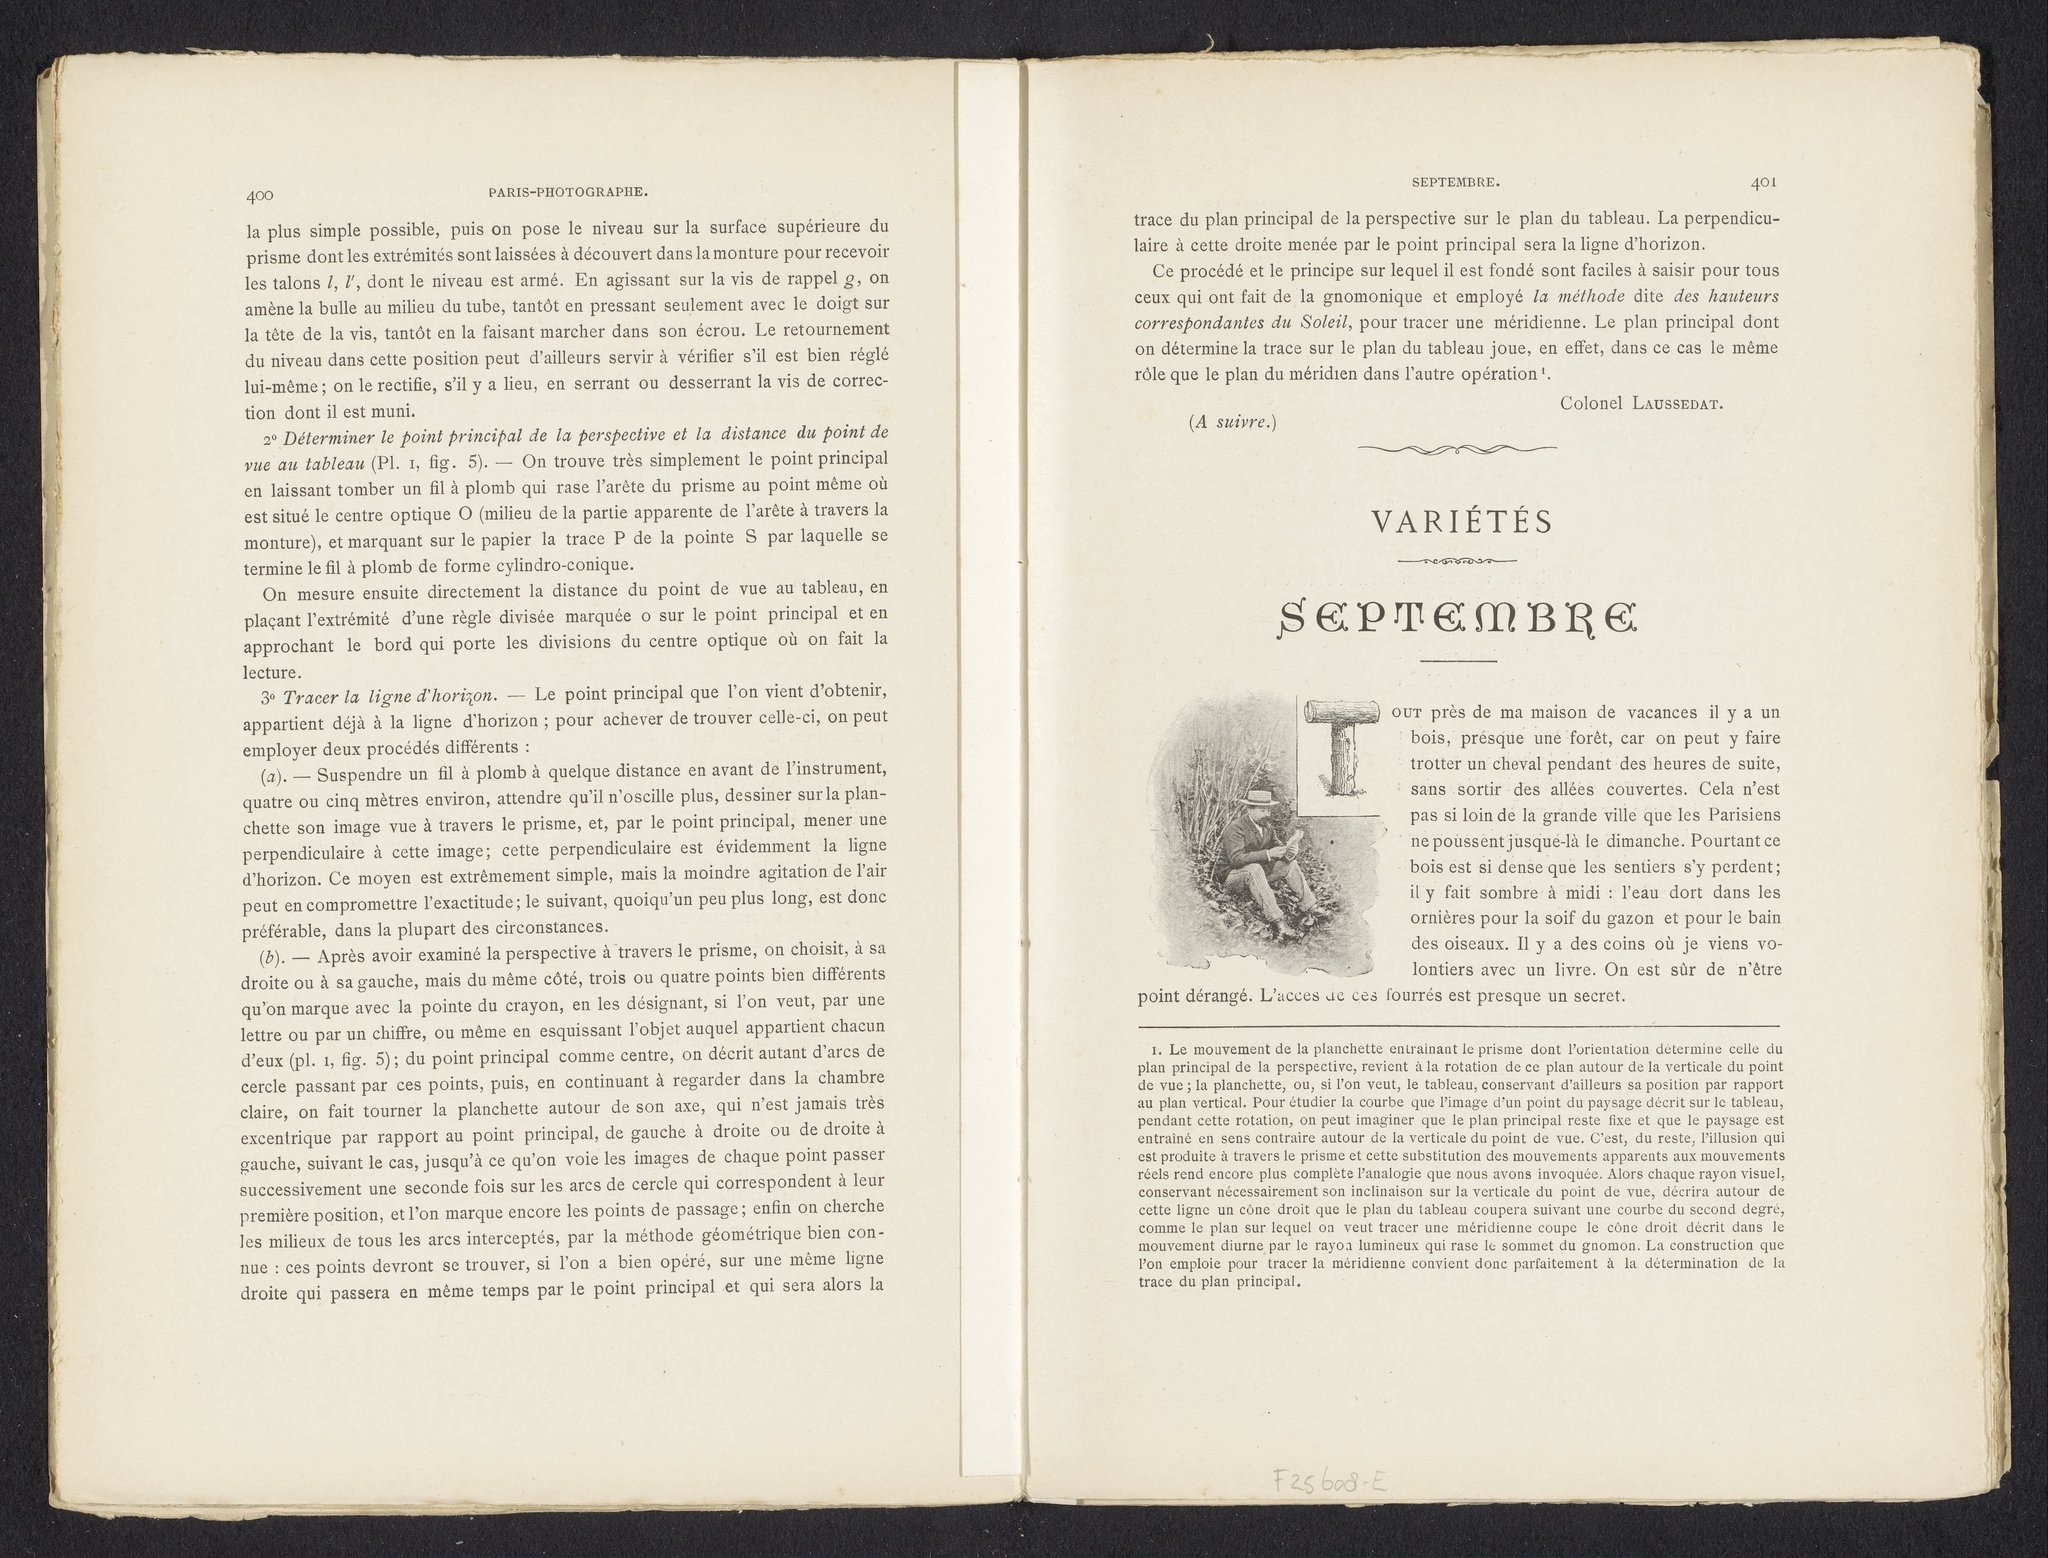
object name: photomechanical print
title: Fotoreproductie van een tekening, voorstellende een zittende man met een brief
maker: Anonymous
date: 1881-1891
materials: paper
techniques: autotype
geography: france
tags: sitting on the ground, letter, envelope